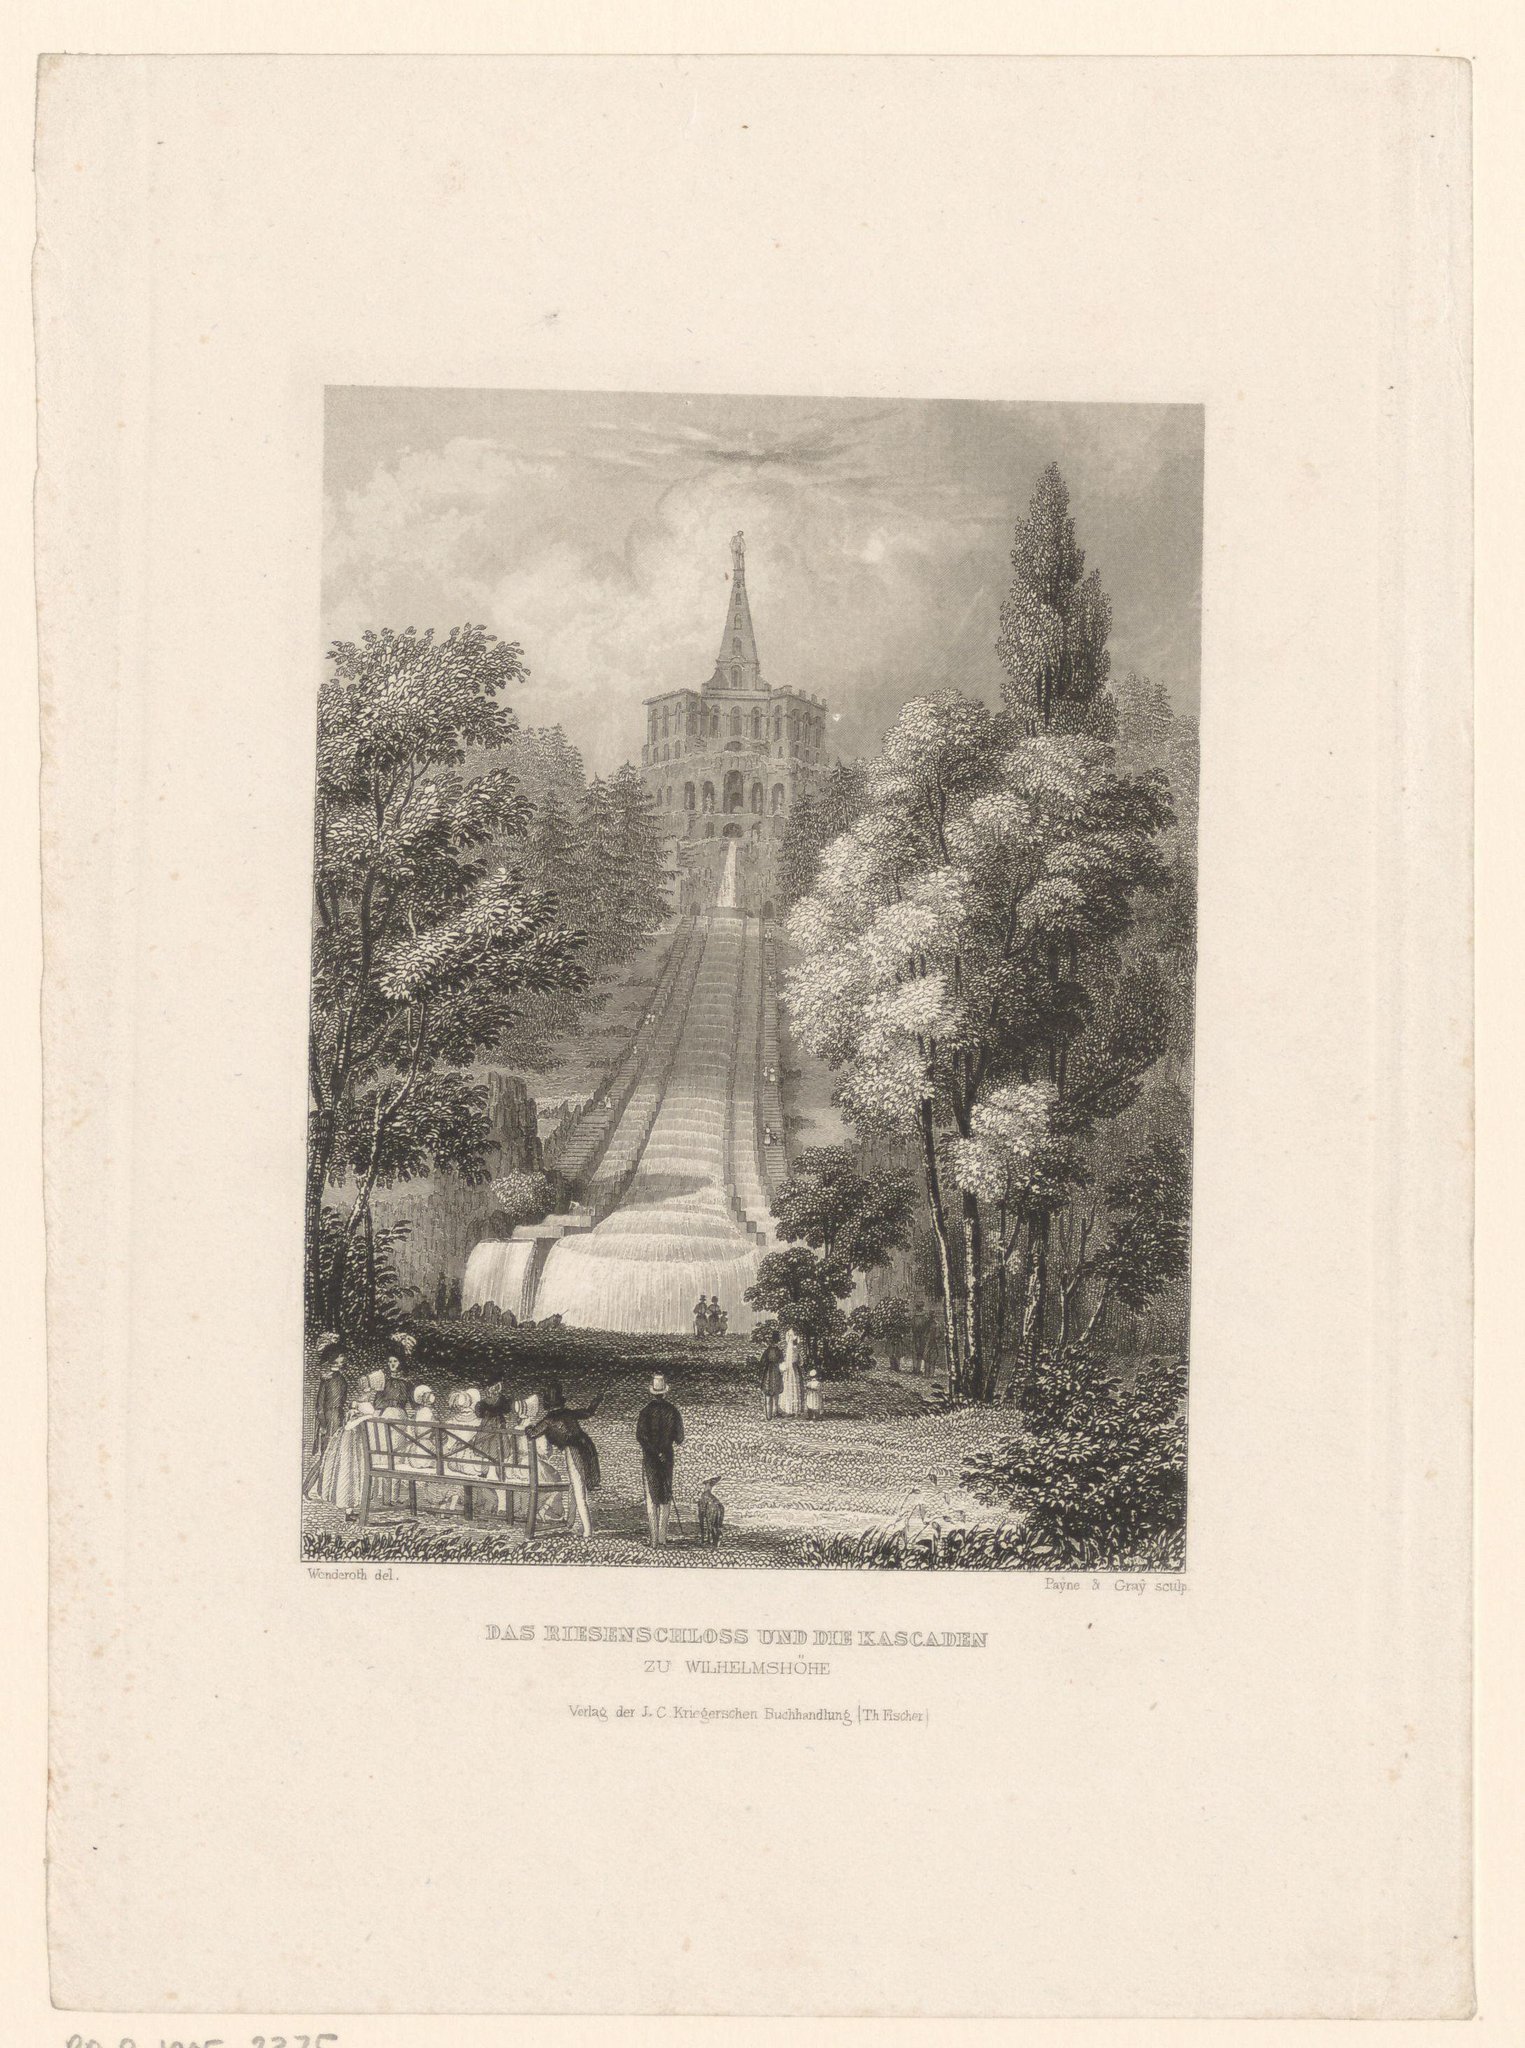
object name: print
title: Gezicht op het Herculesmonument met de cascaden te Wilhelmshöhe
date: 1845-1863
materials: paper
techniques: etching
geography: kassel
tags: english or landscape garden, garden cascade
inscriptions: collector's mark: Lugt 2228